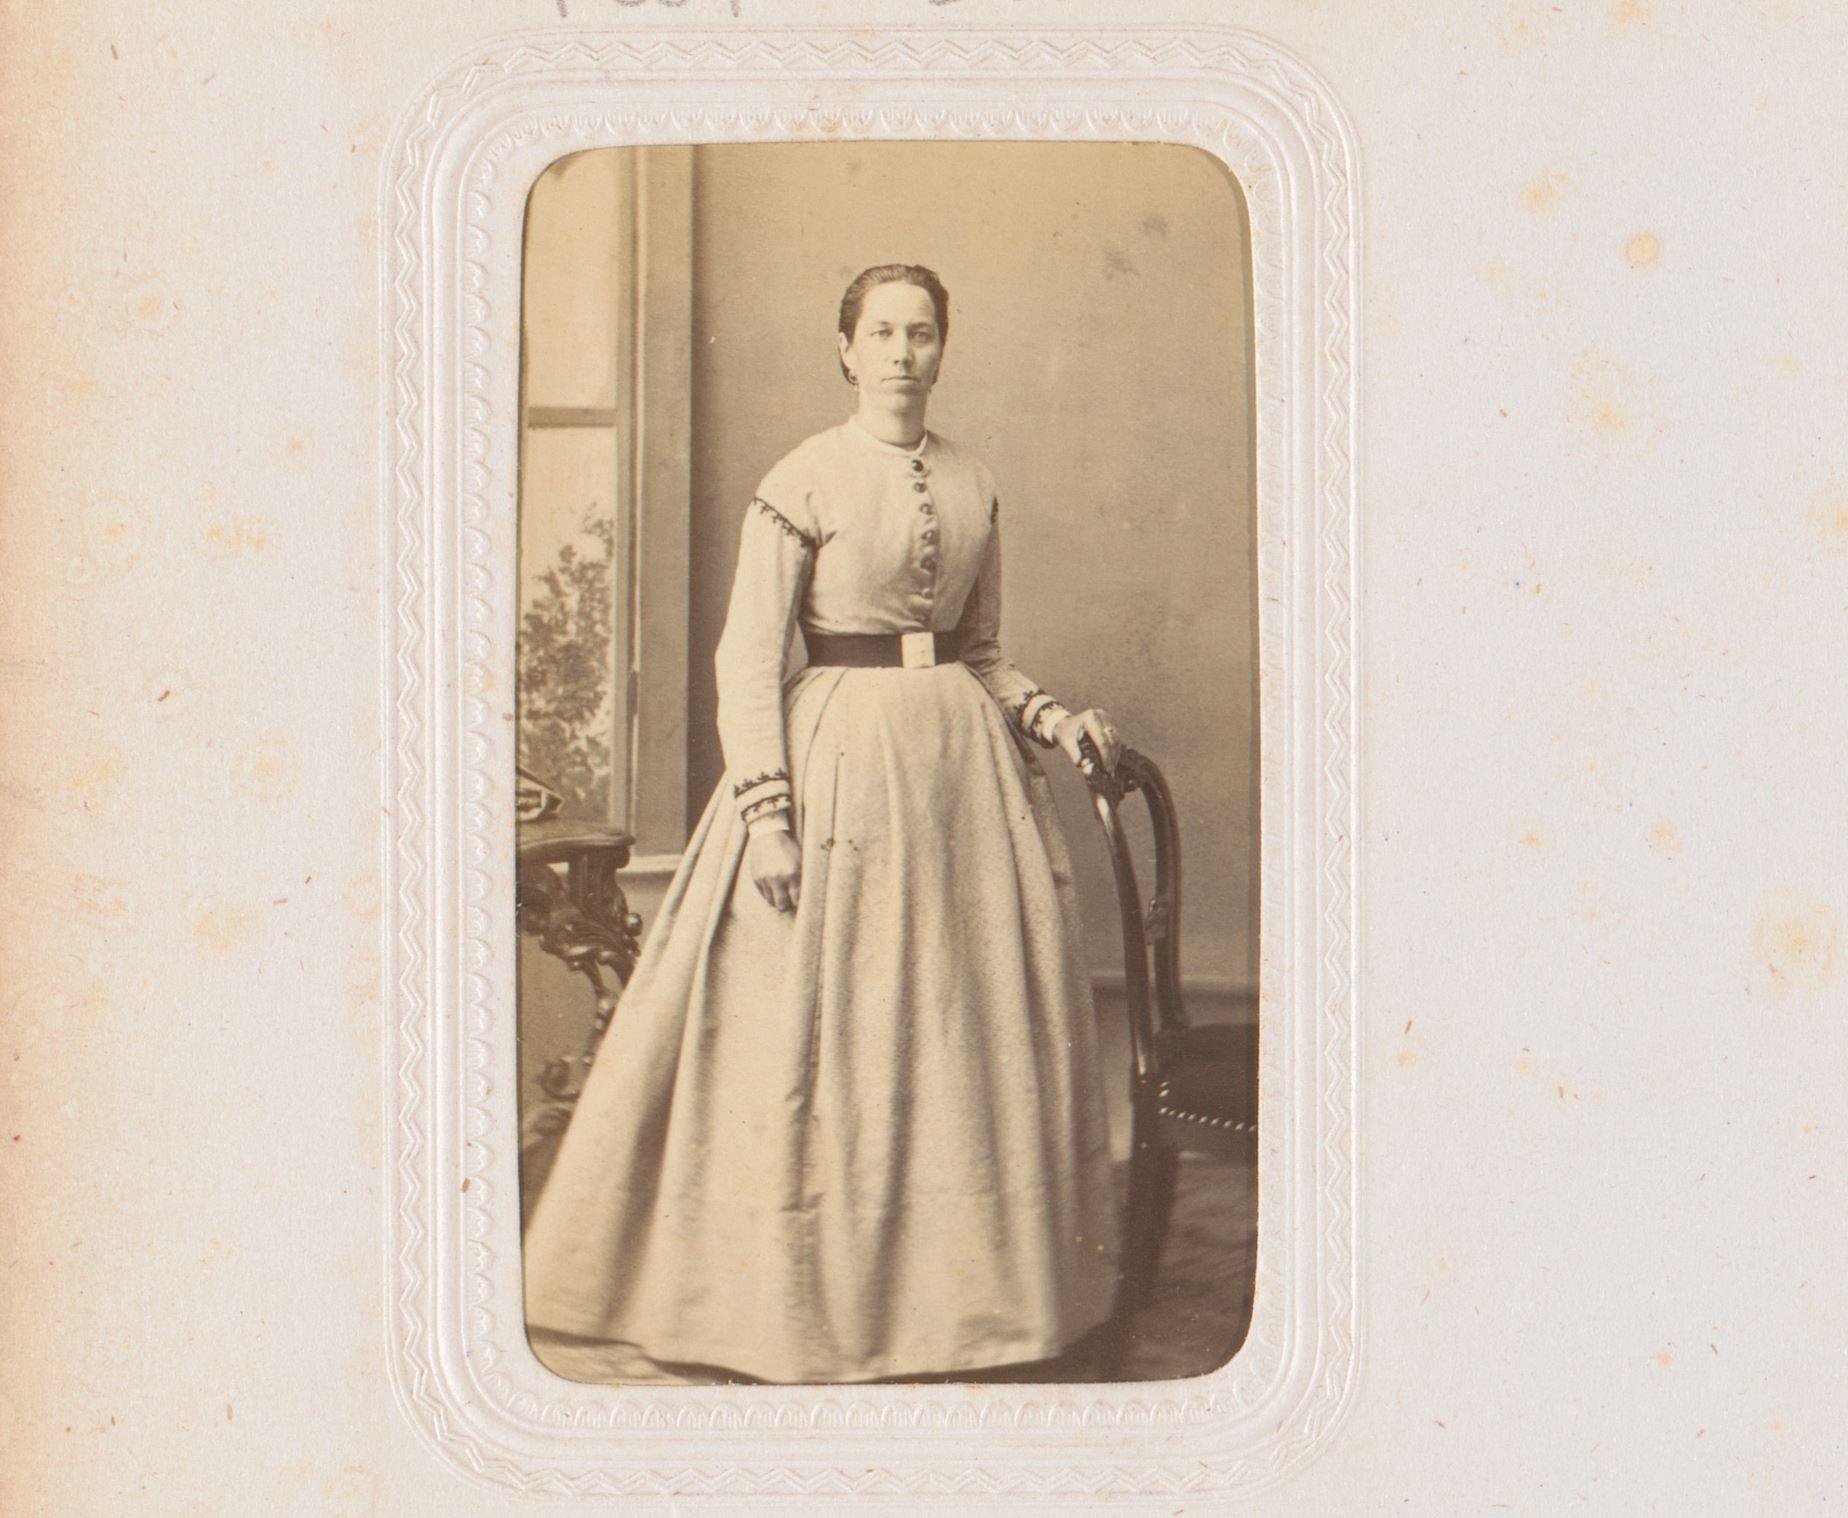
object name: carte de visite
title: Portret van een staande vrouw bij een stoel, aangeduid als Kraayenhoft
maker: kornelis willem schorteldoek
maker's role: boekbinder, fotograaf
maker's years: 1800-1885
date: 1855-1885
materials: cardboard, photographic support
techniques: albumen print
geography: gorinchem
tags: historical persons - bb - woman, standing figure - aa - female human figure, chair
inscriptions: name: ‘Kraaye[n]hoft’, inscription: ‘SCHORTELDOEK, phot.’